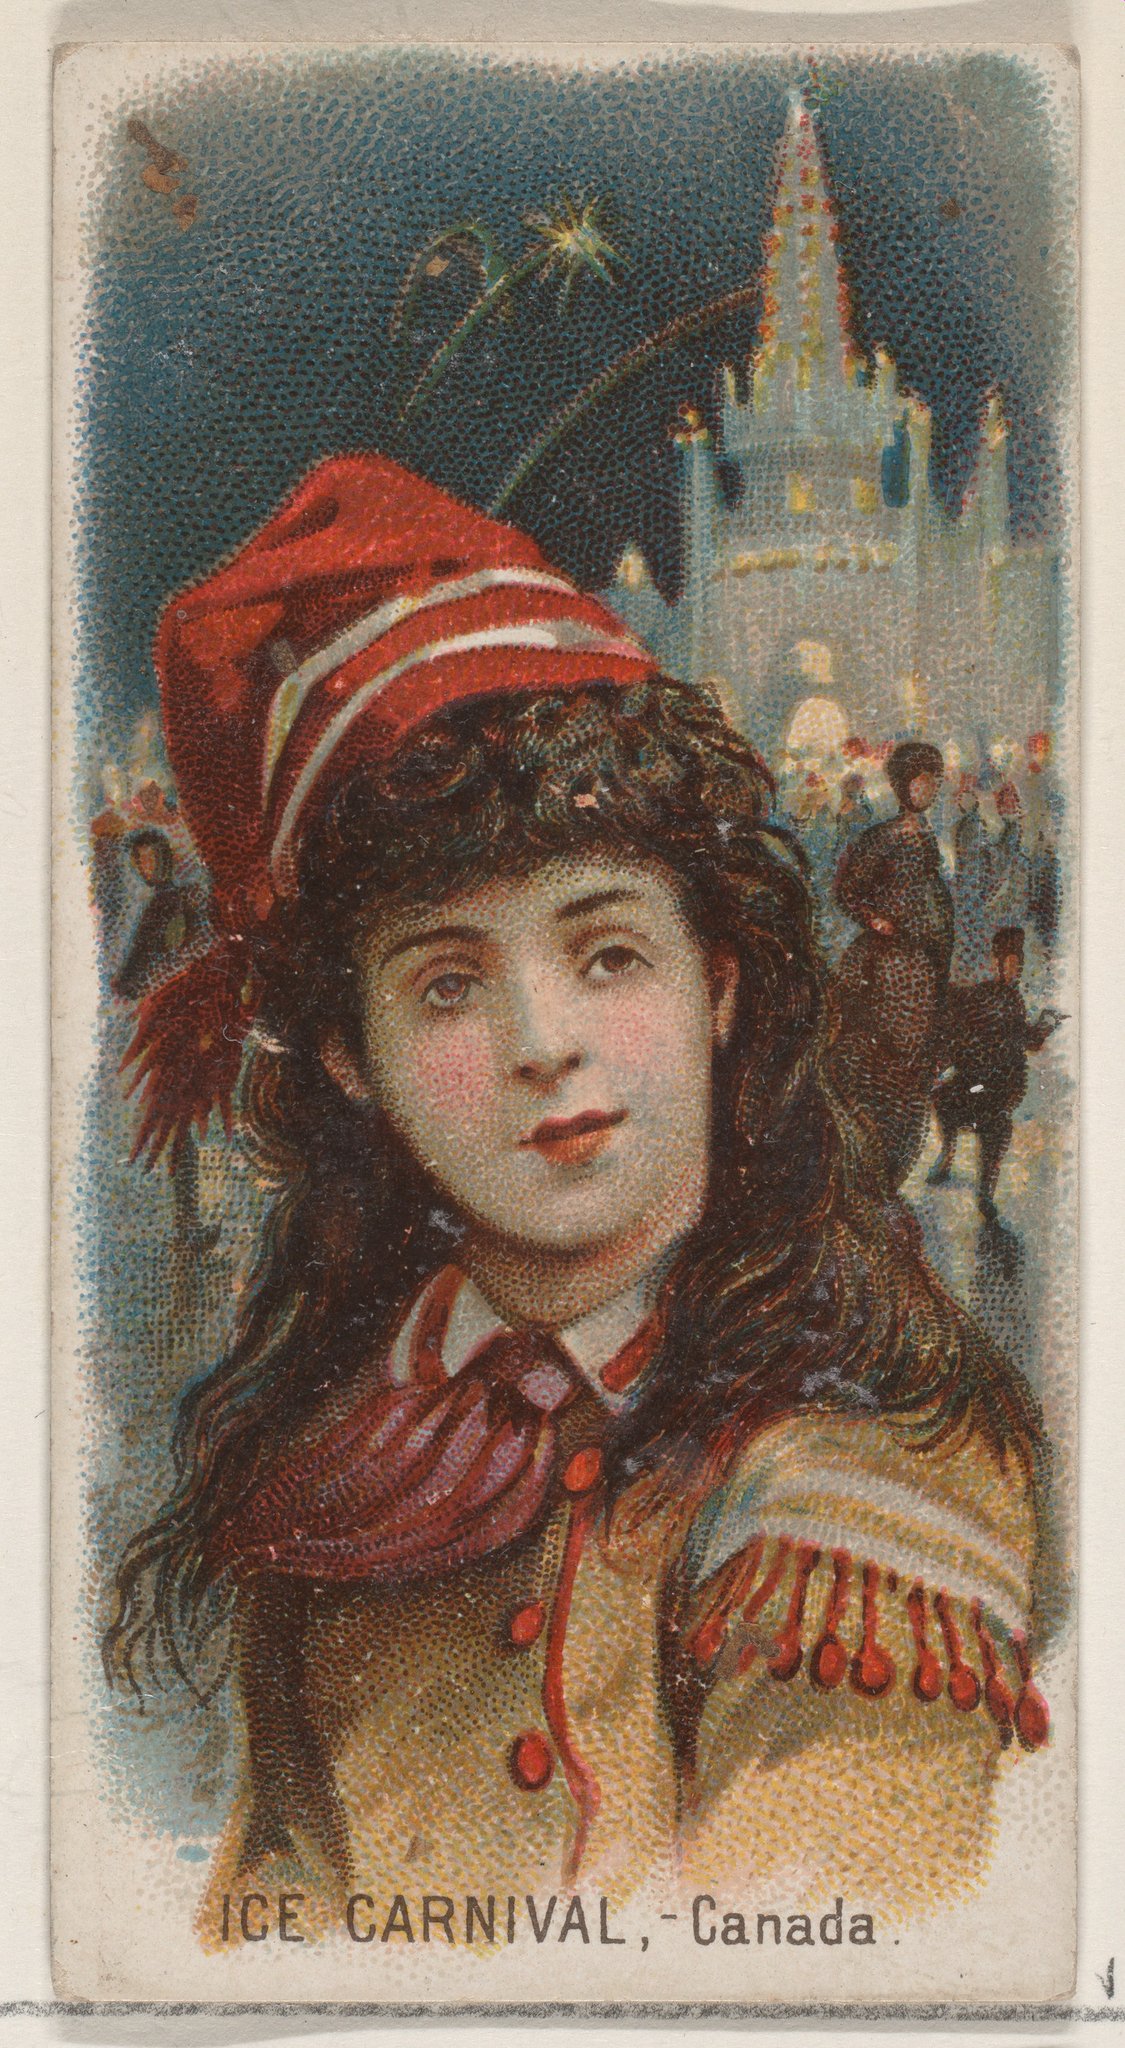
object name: print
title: Ice Carnival, Canada, from the Holidays series (N80) for Duke brand cigarettes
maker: w. duke, sons & co.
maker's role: publisher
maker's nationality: american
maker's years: 1870-1920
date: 1890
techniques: color lithograph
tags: women